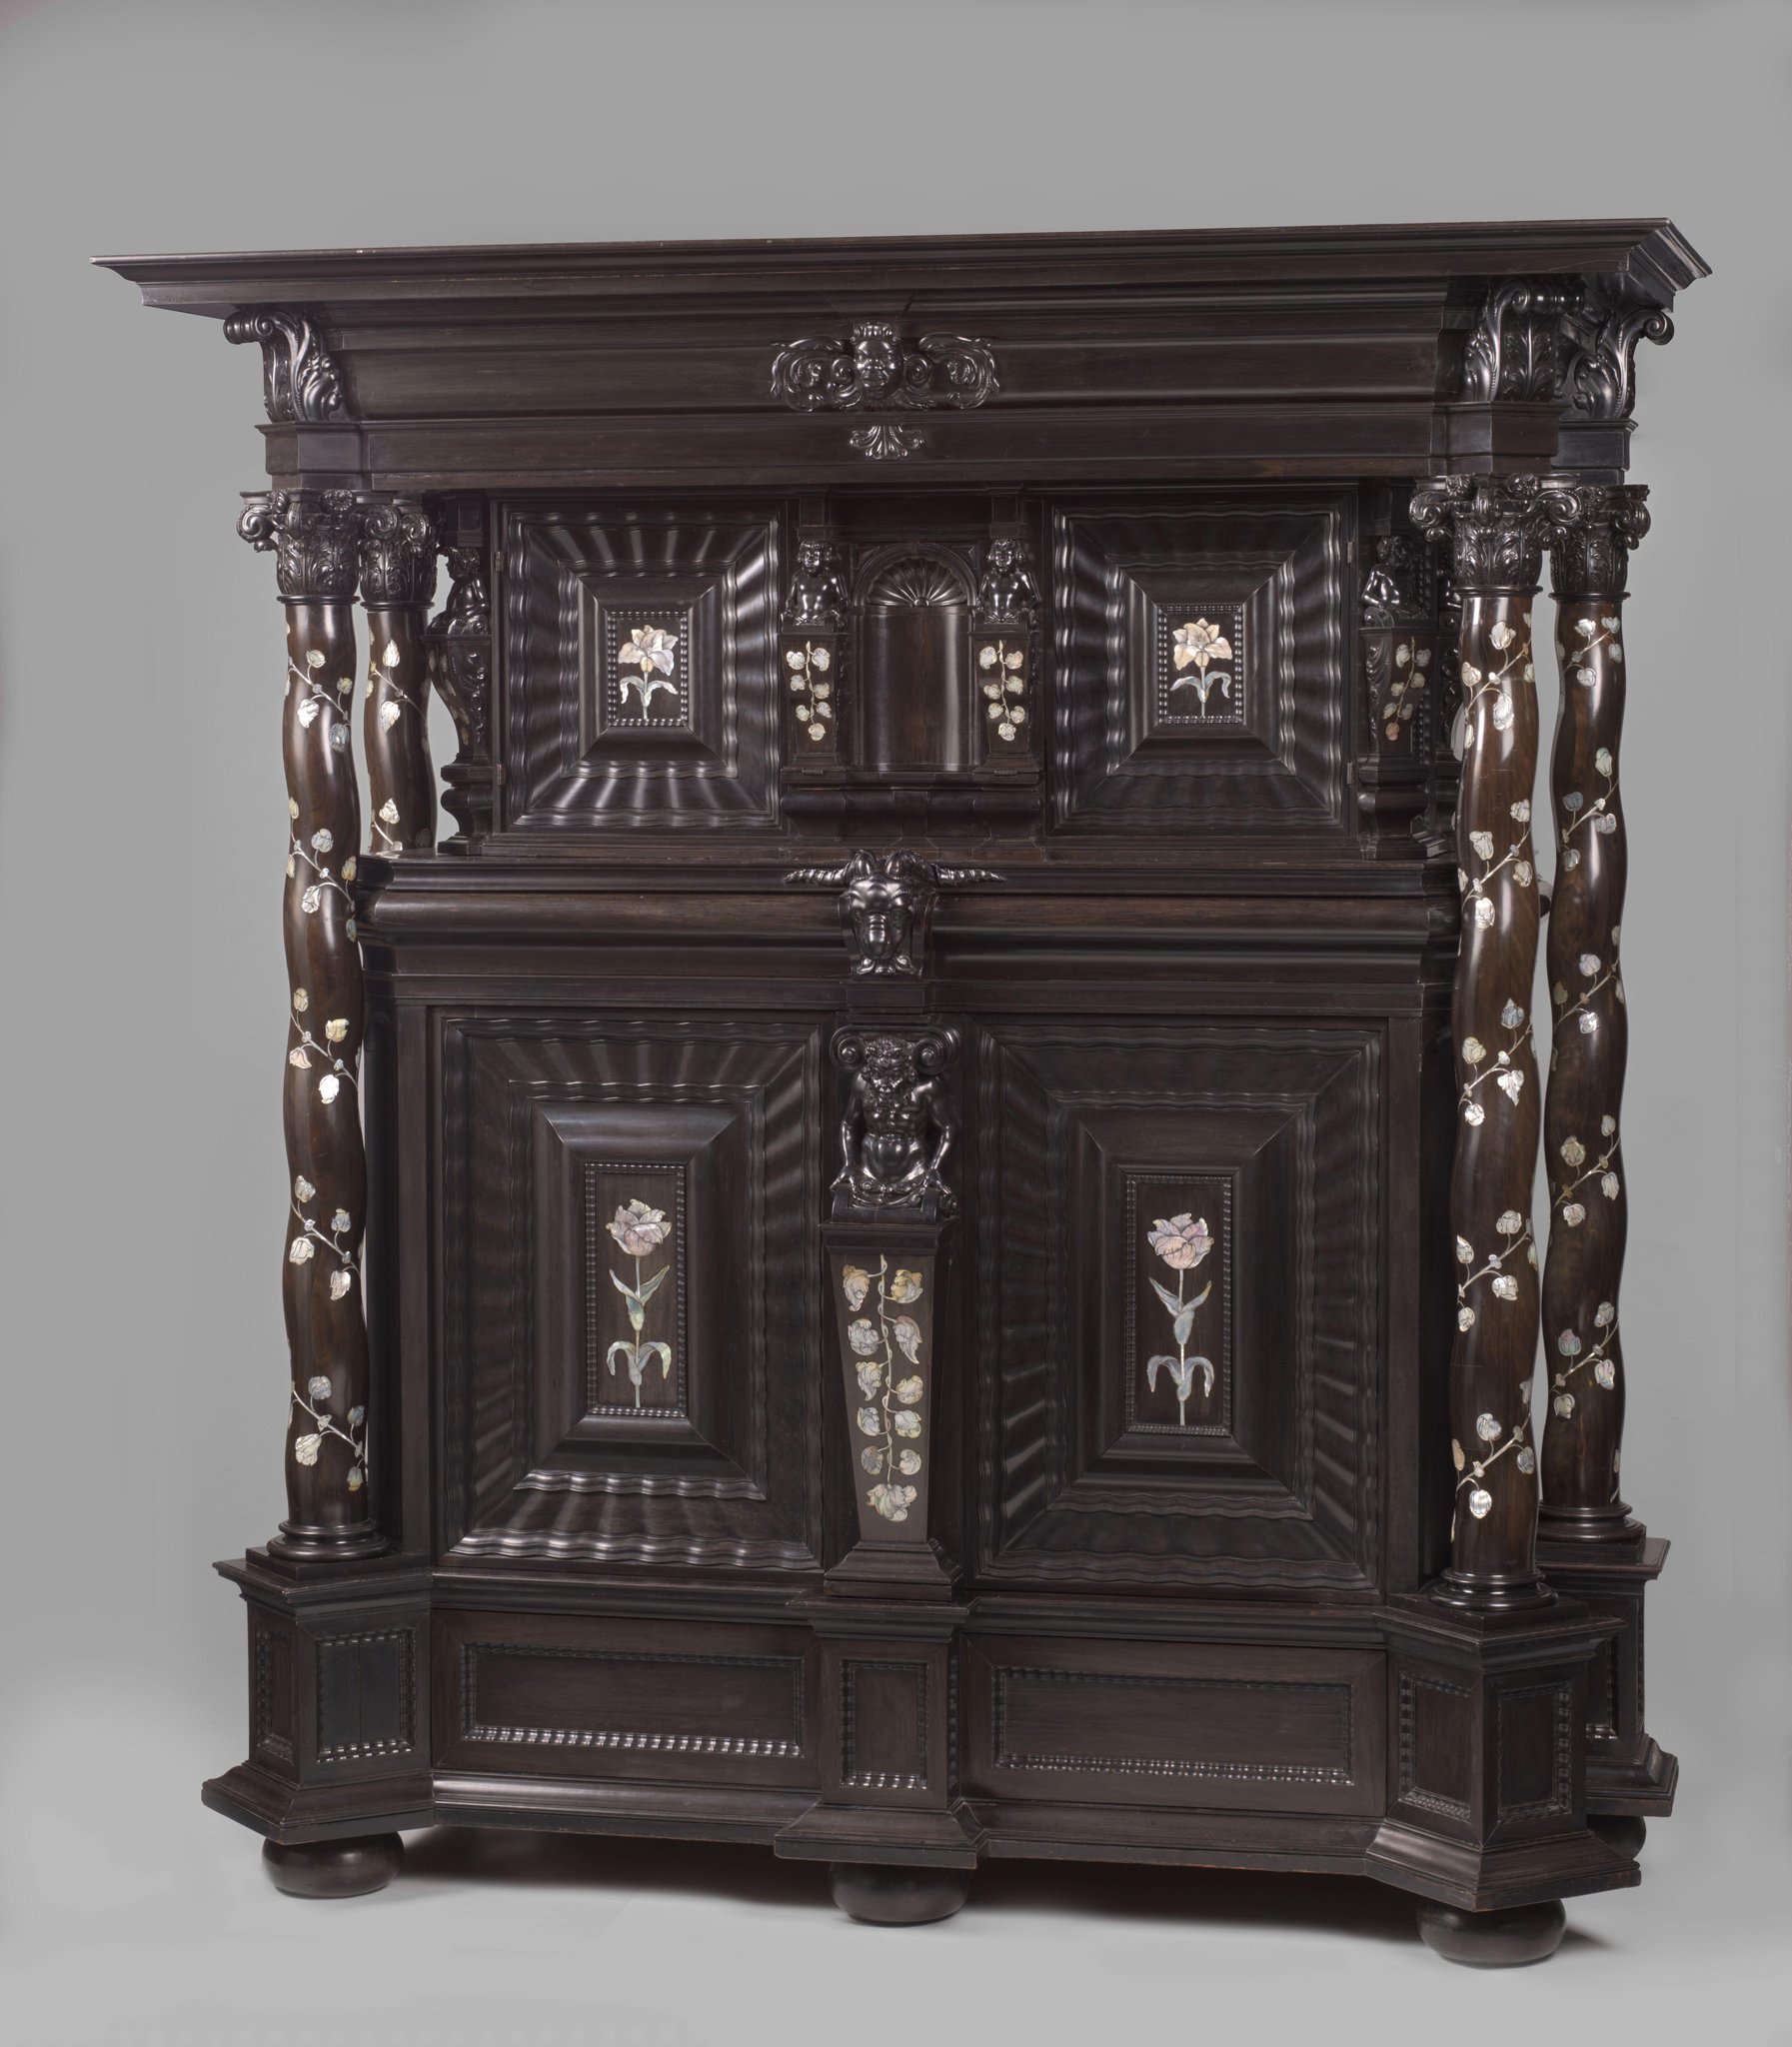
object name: case furniture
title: Cupboard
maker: herman doomer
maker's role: woodworker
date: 1635-1645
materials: wood, ivory, mother of pearl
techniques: marquetry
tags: ram's head ~ ornament, column, pillar ~ architecture, flowers ~ ornament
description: This cupboard is a work of art showcasing a remarkable interplay of forms and materials. The precious, tropical ebony is glued on the oak and inlaid with mother-of pearl, thus hiding the wood carcass. Herman Doomer made this cupboard ten years after its counterpart, also on view here. The large, twisted columns give this cupboard its monumental character. Rembrandt, who undoubtedly admired Doomer’s work, immortalized the cabinetmaker and his wife in pendants in 1640.